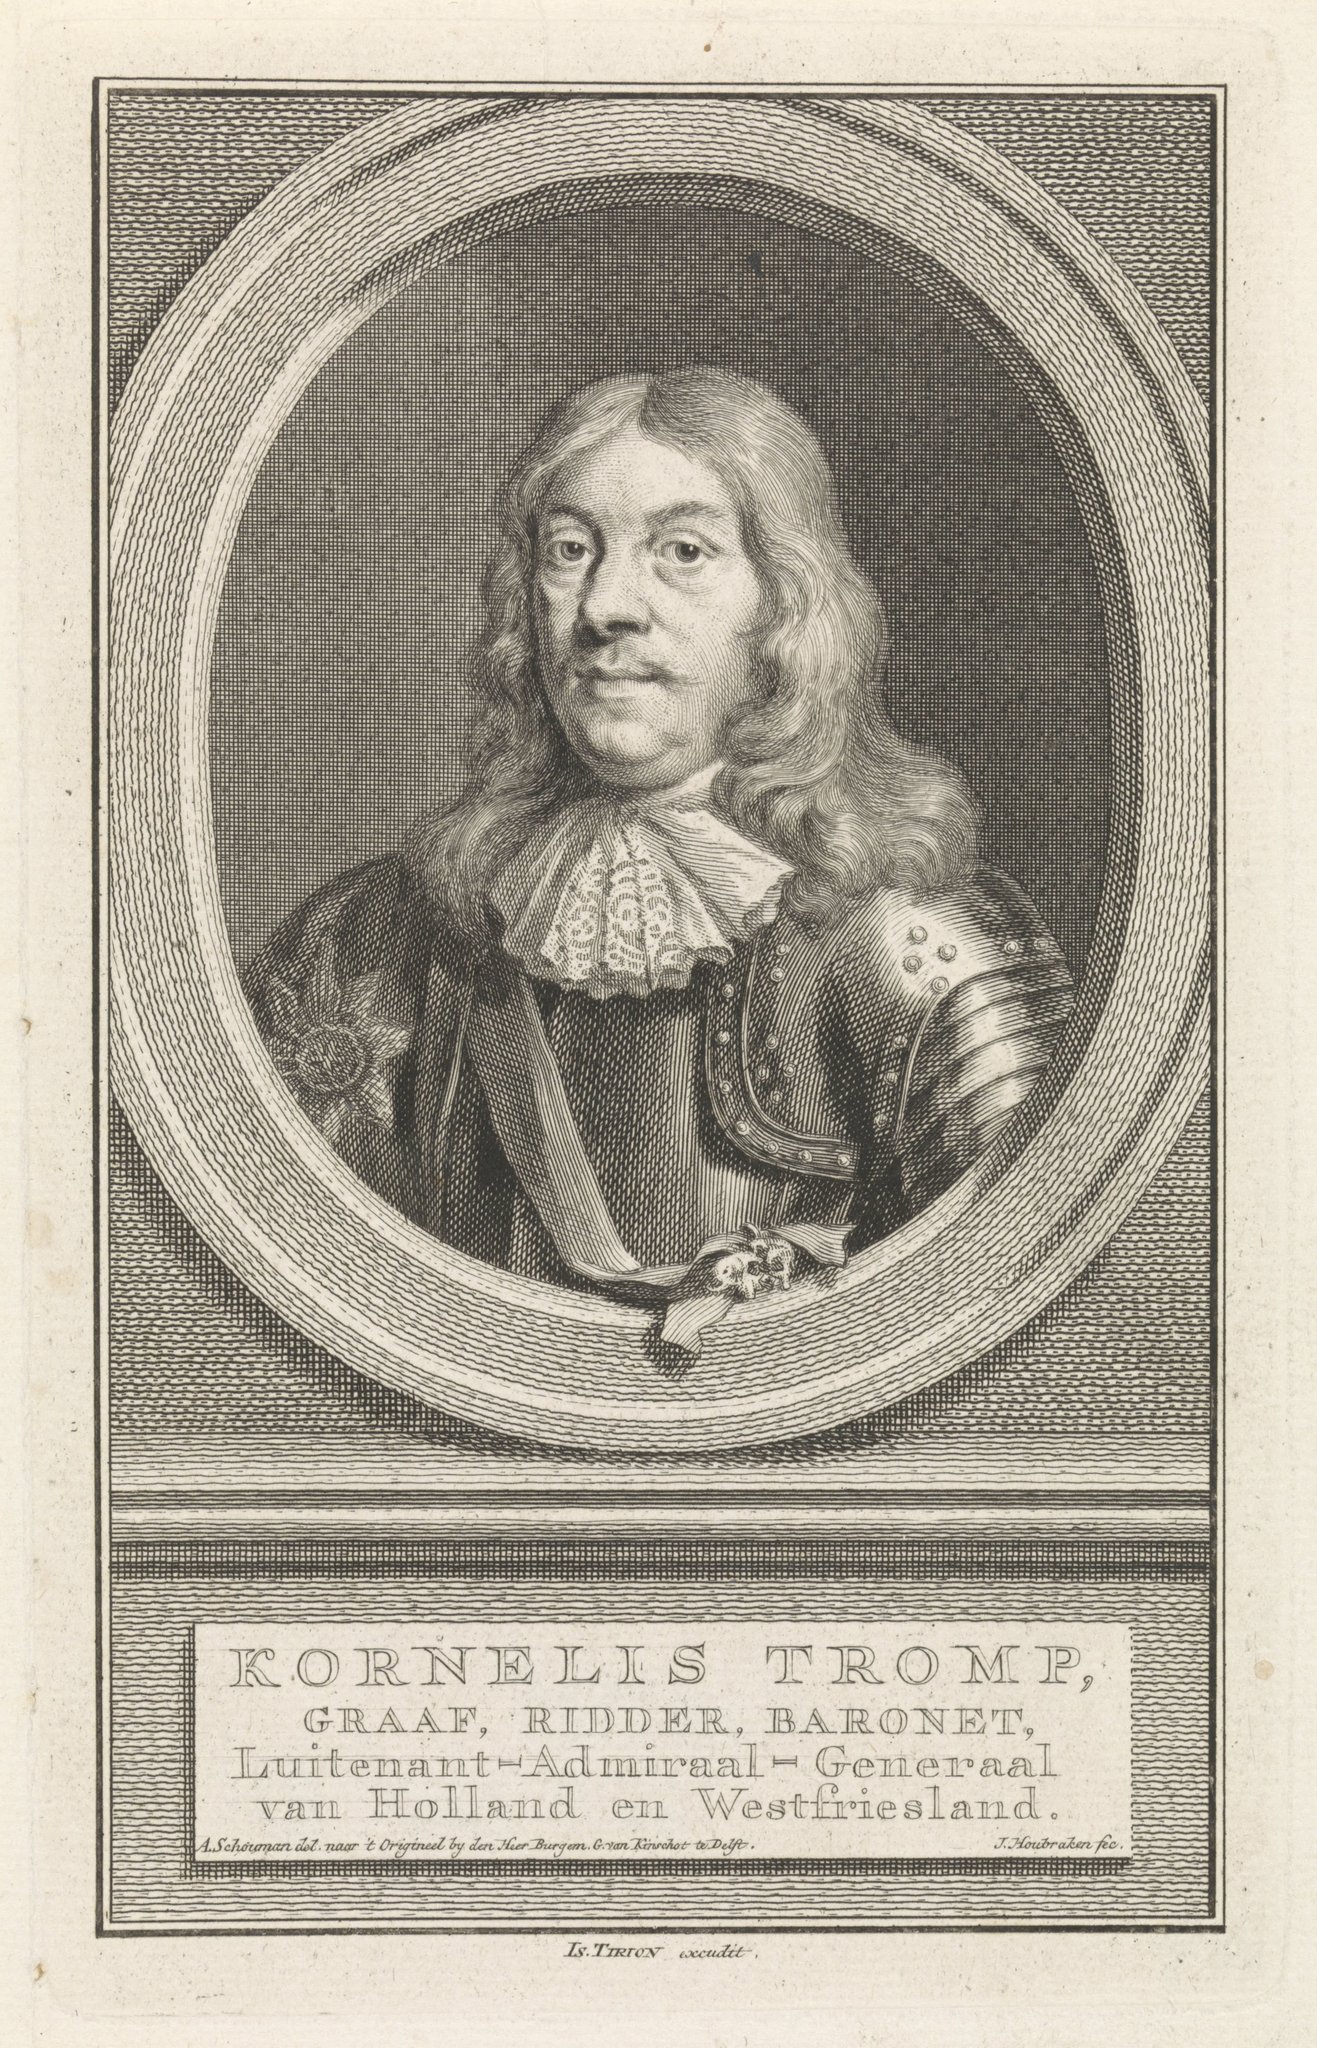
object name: print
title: Portret van Cornelis Tromp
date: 1749-1759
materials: paper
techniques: engraving, etching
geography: amsterdam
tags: rotterdam, amsterdam, cornelis tromp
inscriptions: collector's mark: Lugt 2228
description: Buste naar links van Cornelis Tromp, gekleed in een harnas, in een ovaal, waarbij zijn teken van de Orde van de Olifant over de rand steekt. Het portret rust op een richel waarop zijn naam en titel in drie regels in het Nederlands.